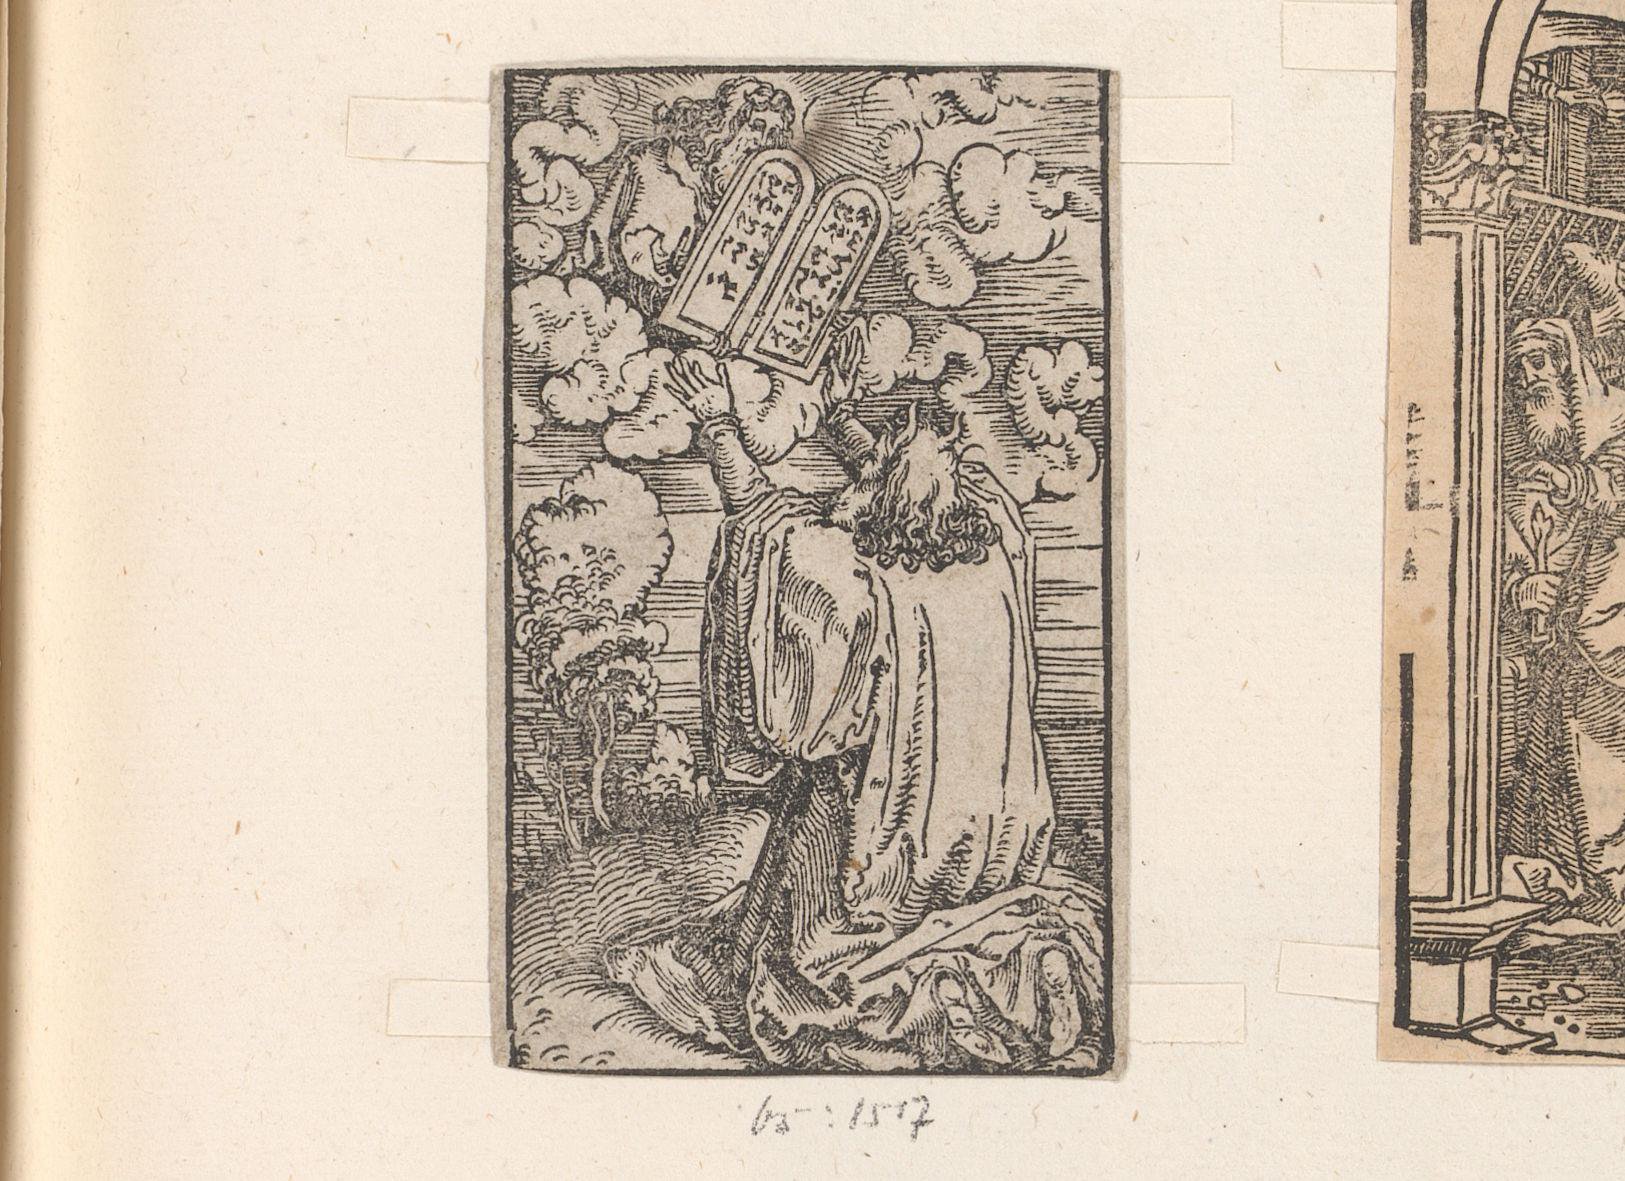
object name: album leaf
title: Mozes met de wetstafelen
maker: Anonymous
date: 1500-1536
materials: paper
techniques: woodcut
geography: germany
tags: moses receives the tables of the law from god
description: Mozes ontvangt de wetstafelen met daarop de tien geboden van God de Vader. Prent maakt deel uit van een album.